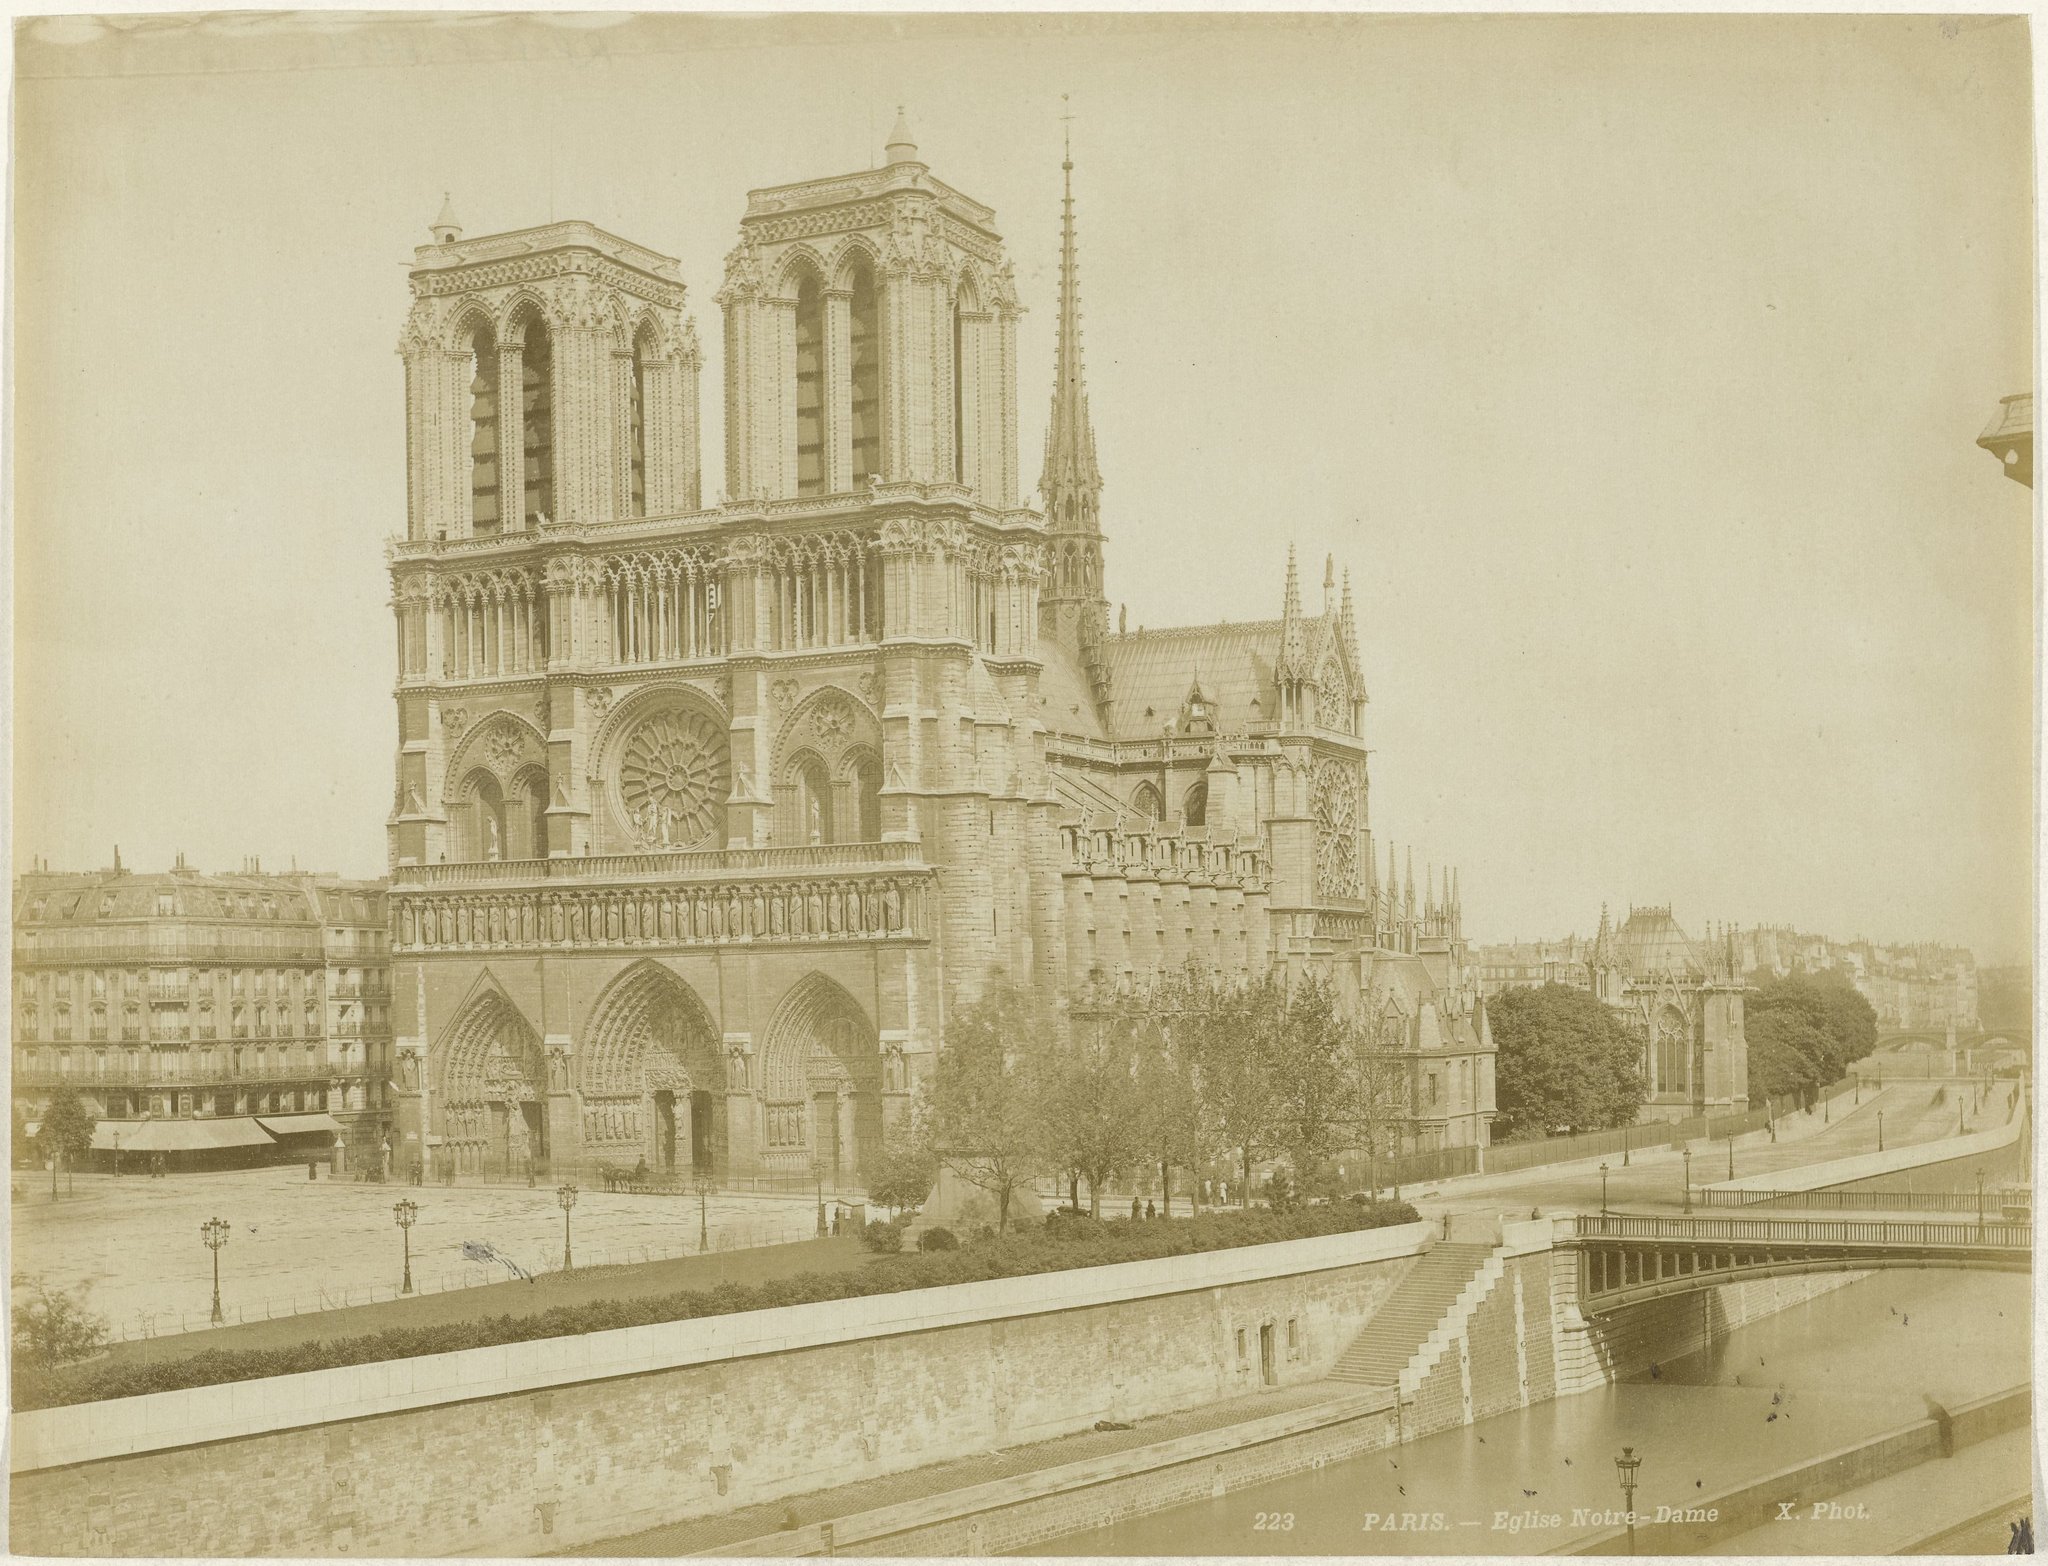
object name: photograph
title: Paris. - Eglise Notre-Dame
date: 1887-1900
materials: paper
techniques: albumen print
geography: paris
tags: church (exterior)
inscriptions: inscription: ‘223 Paris. - Eglise Notre-Dame X. Phot.’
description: Tussen 1887 en ca. 1900 werkten Neurdein frères onder andere onder de naam 'X phot.'.